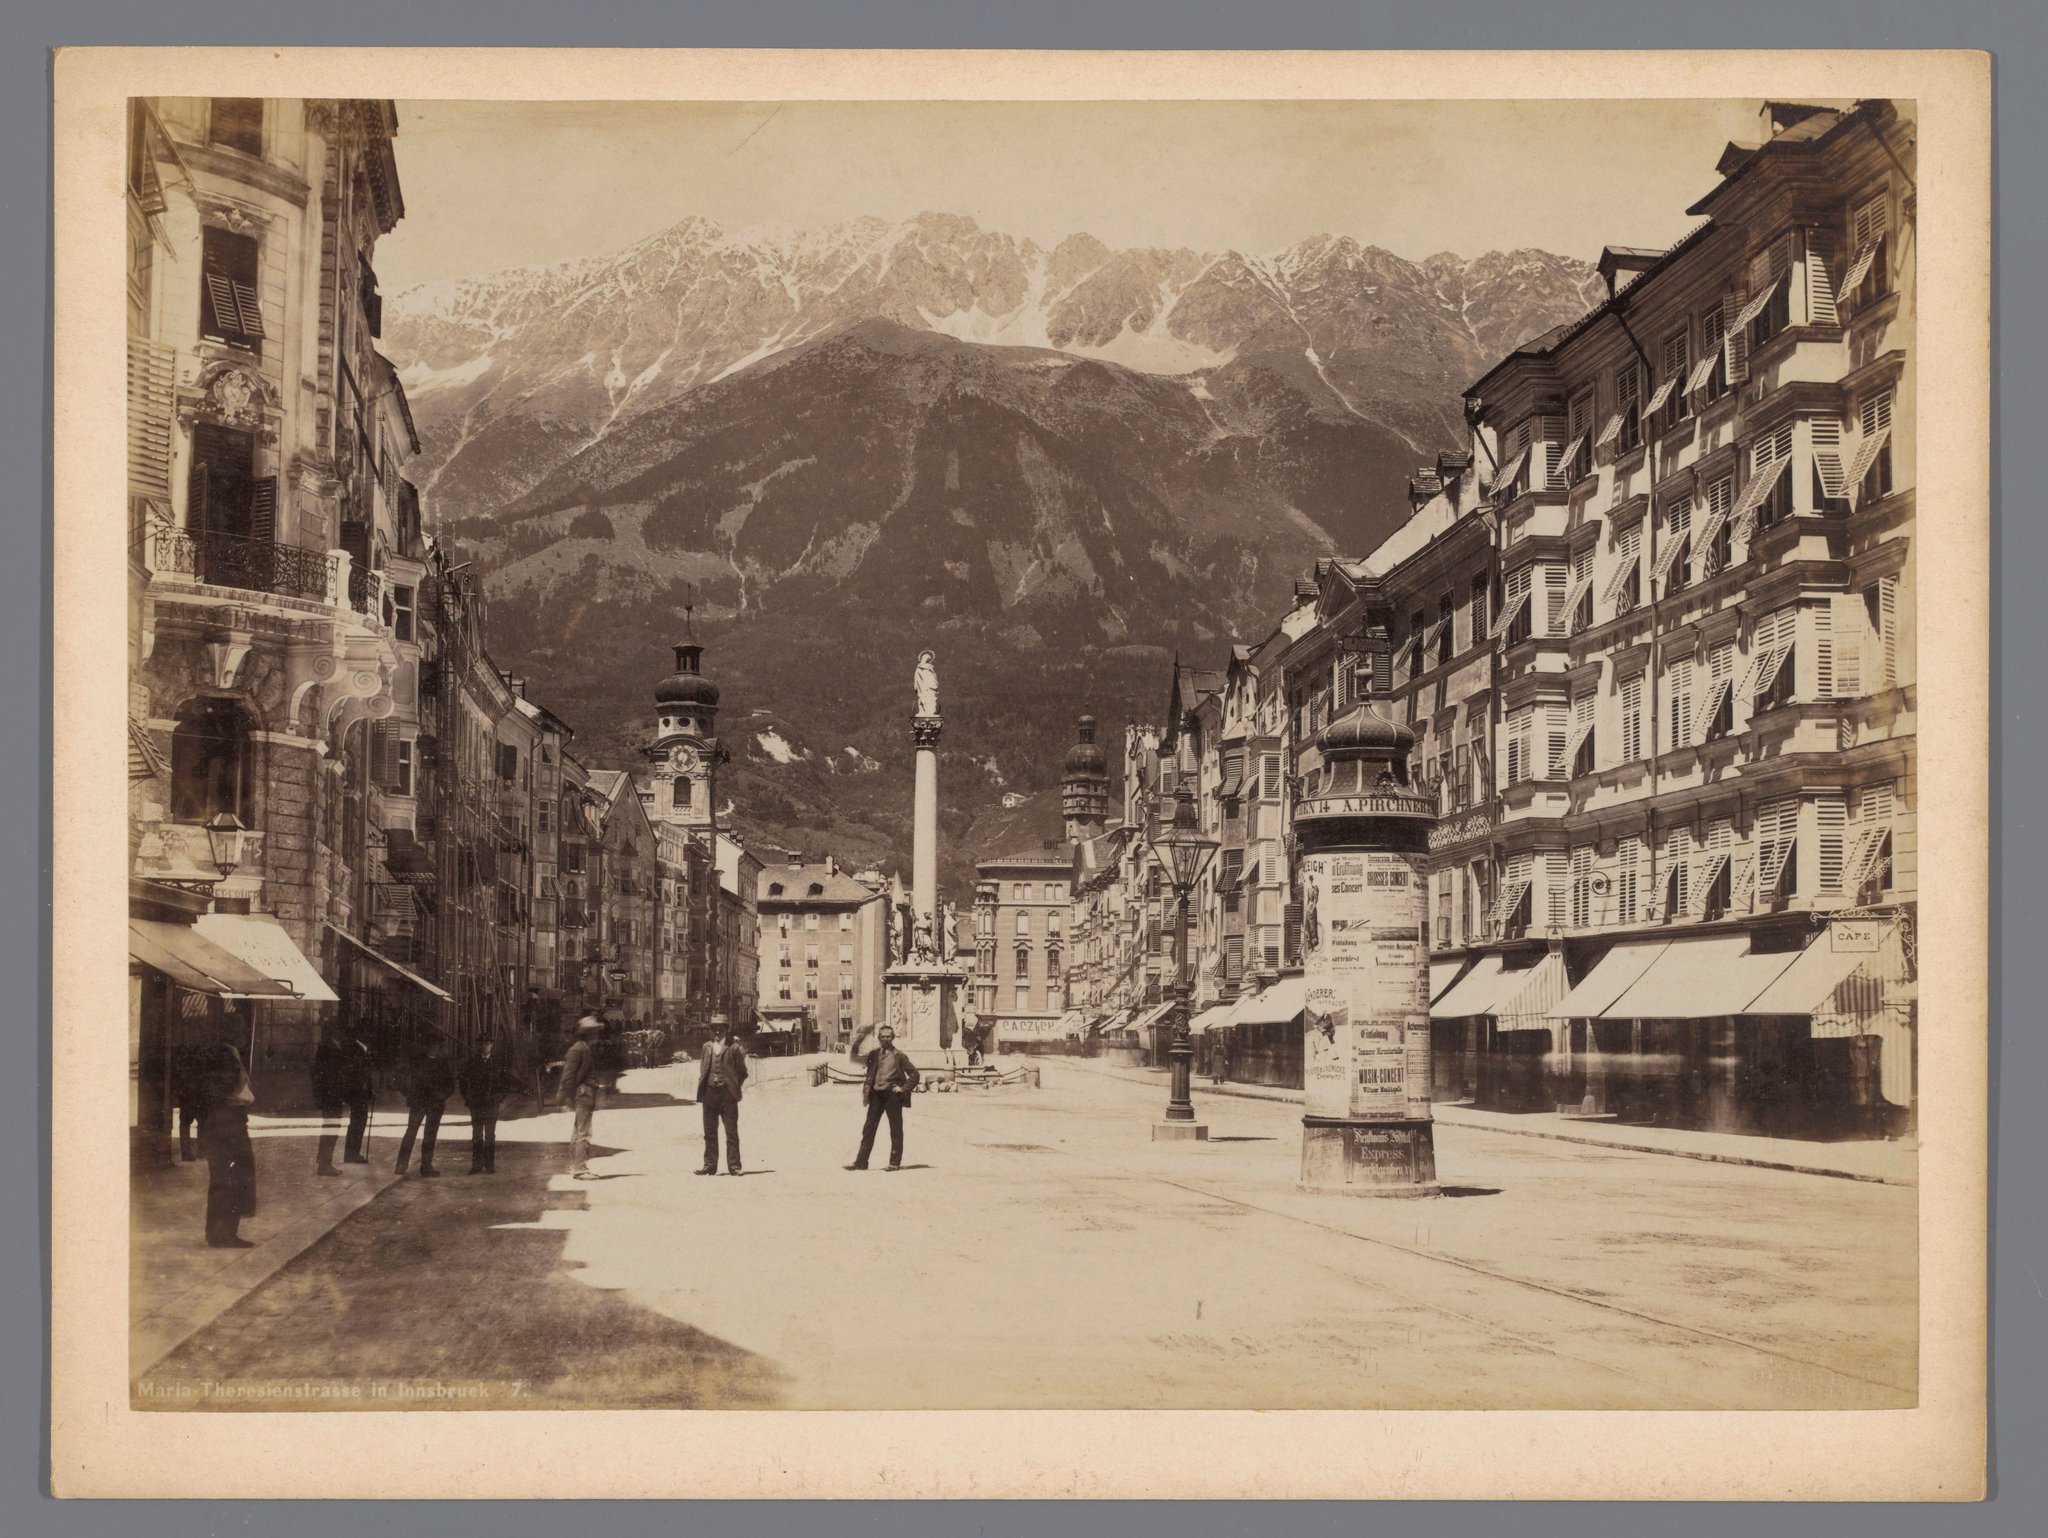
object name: photograph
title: Maria-Theresienstrasse in Innsbruck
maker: fritz gratl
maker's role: publisher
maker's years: 1870-1948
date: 1850-1920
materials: cardboard, paper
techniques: albumen print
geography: innsbruck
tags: urban housing, street, mountains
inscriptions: number: ‘7’